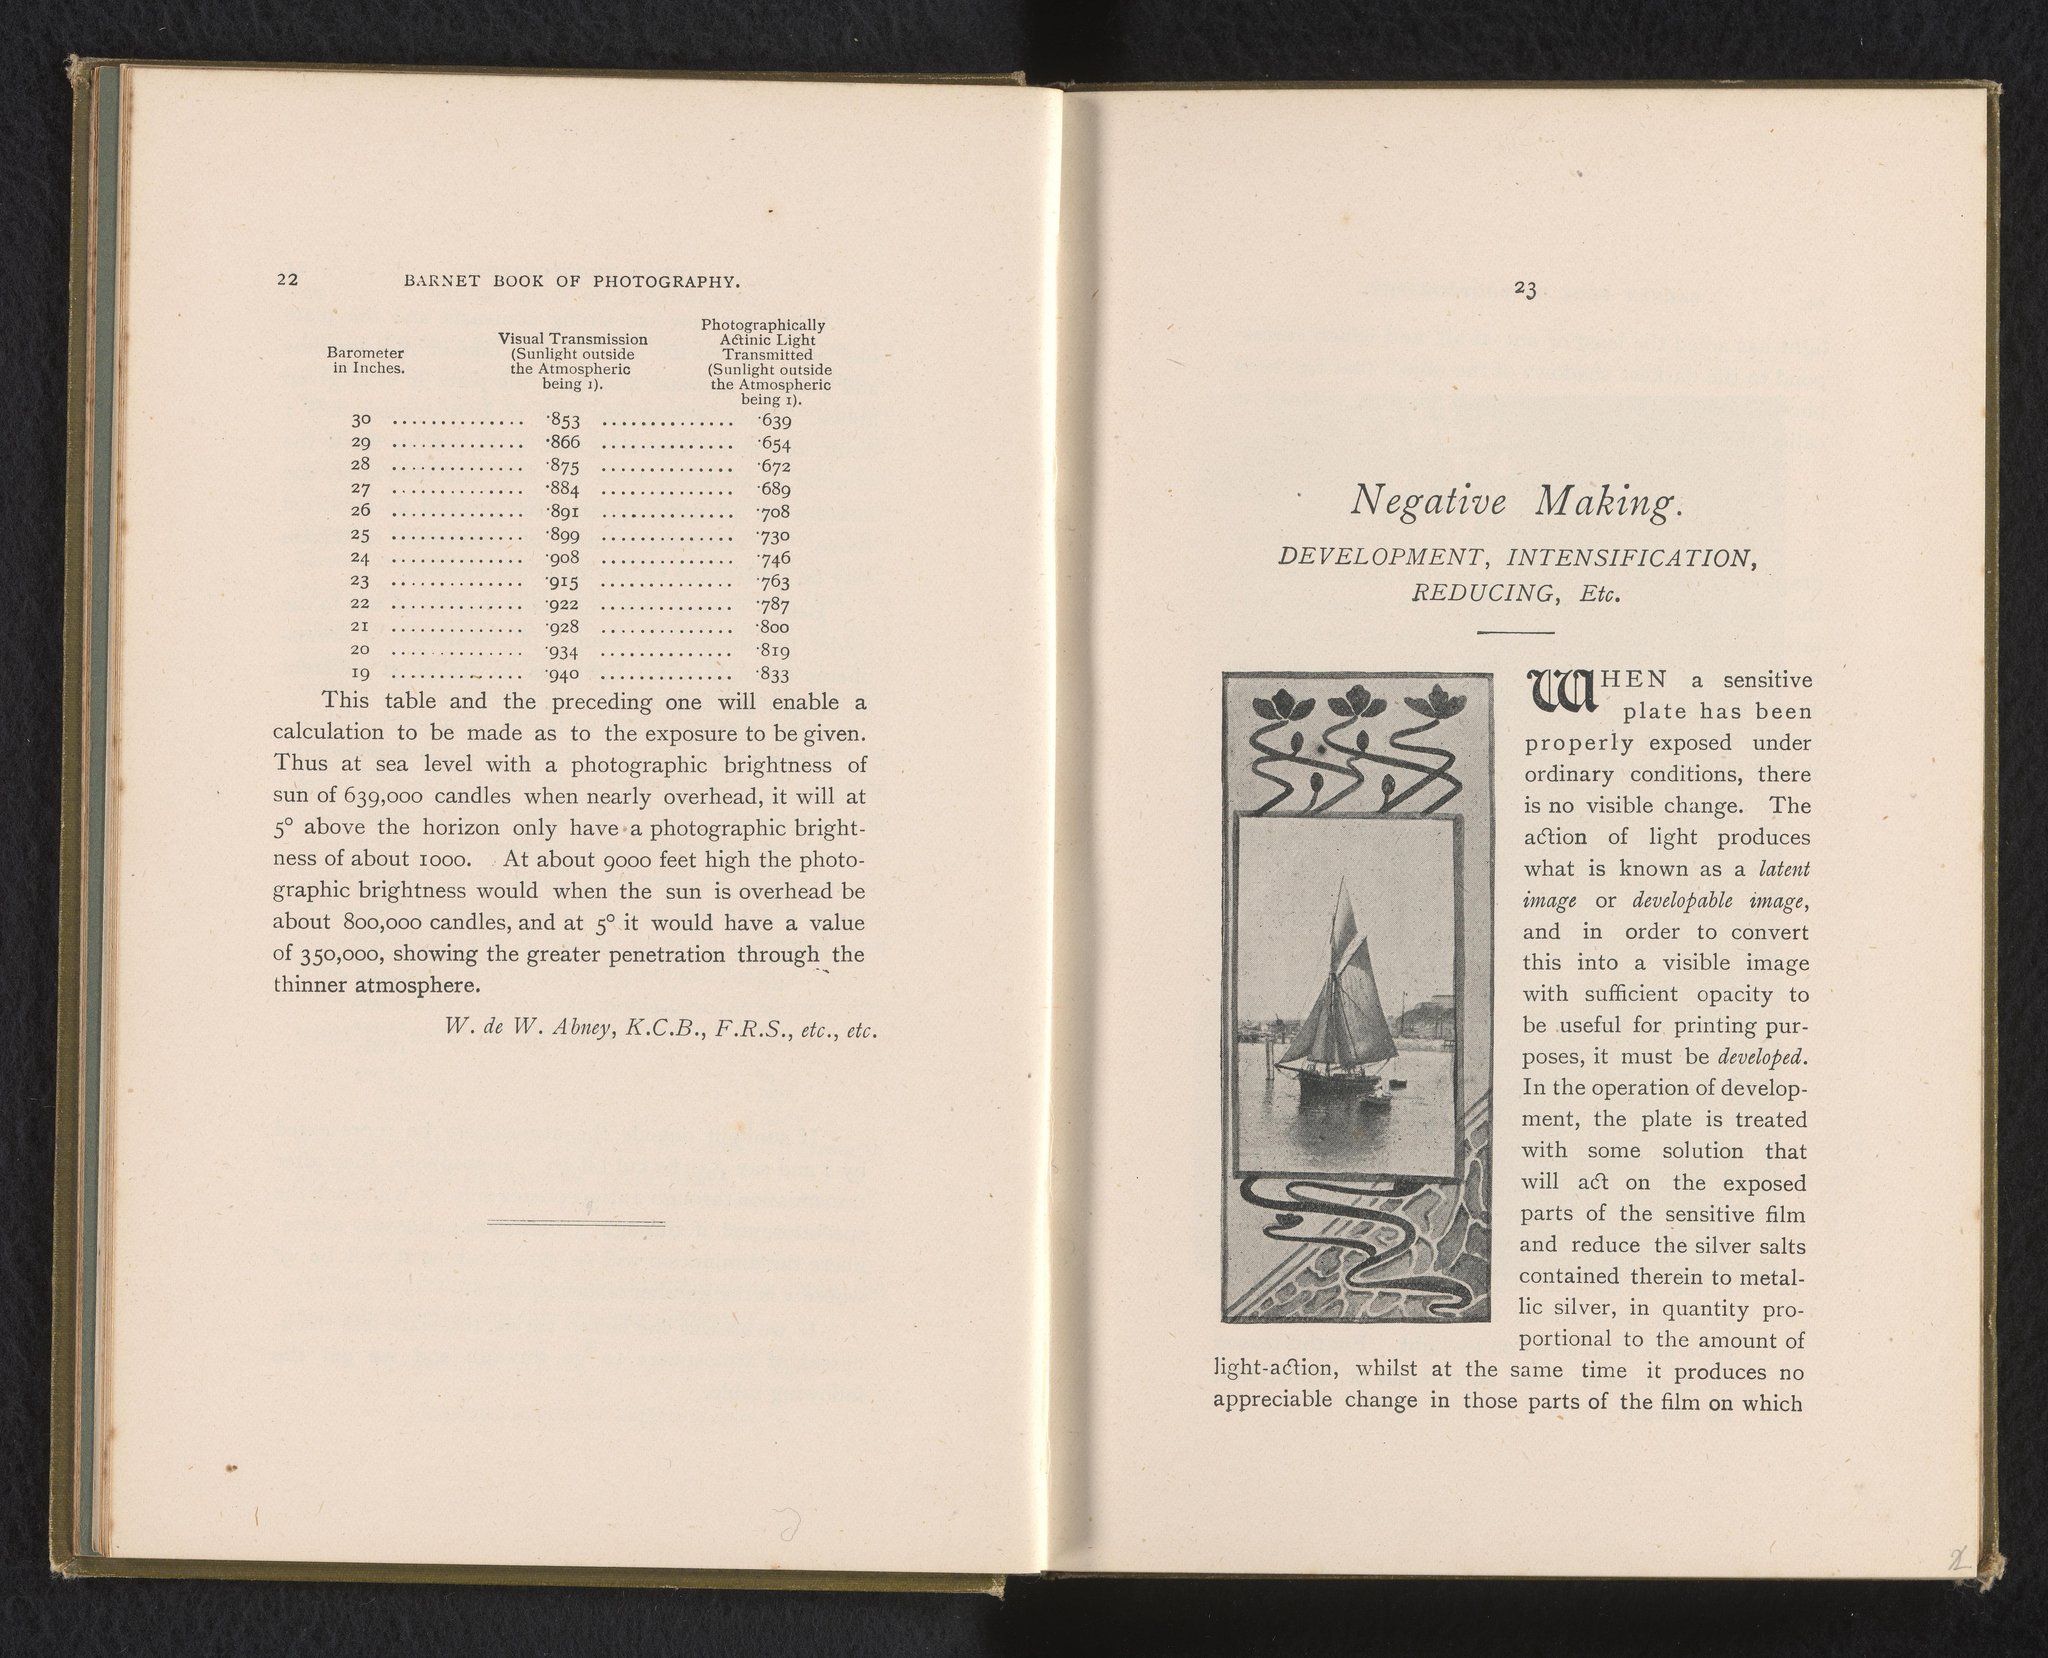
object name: page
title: Zeilboot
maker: Anonymous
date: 1895-1900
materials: paper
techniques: letterpress printing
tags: sailing-ship, sailing-boat